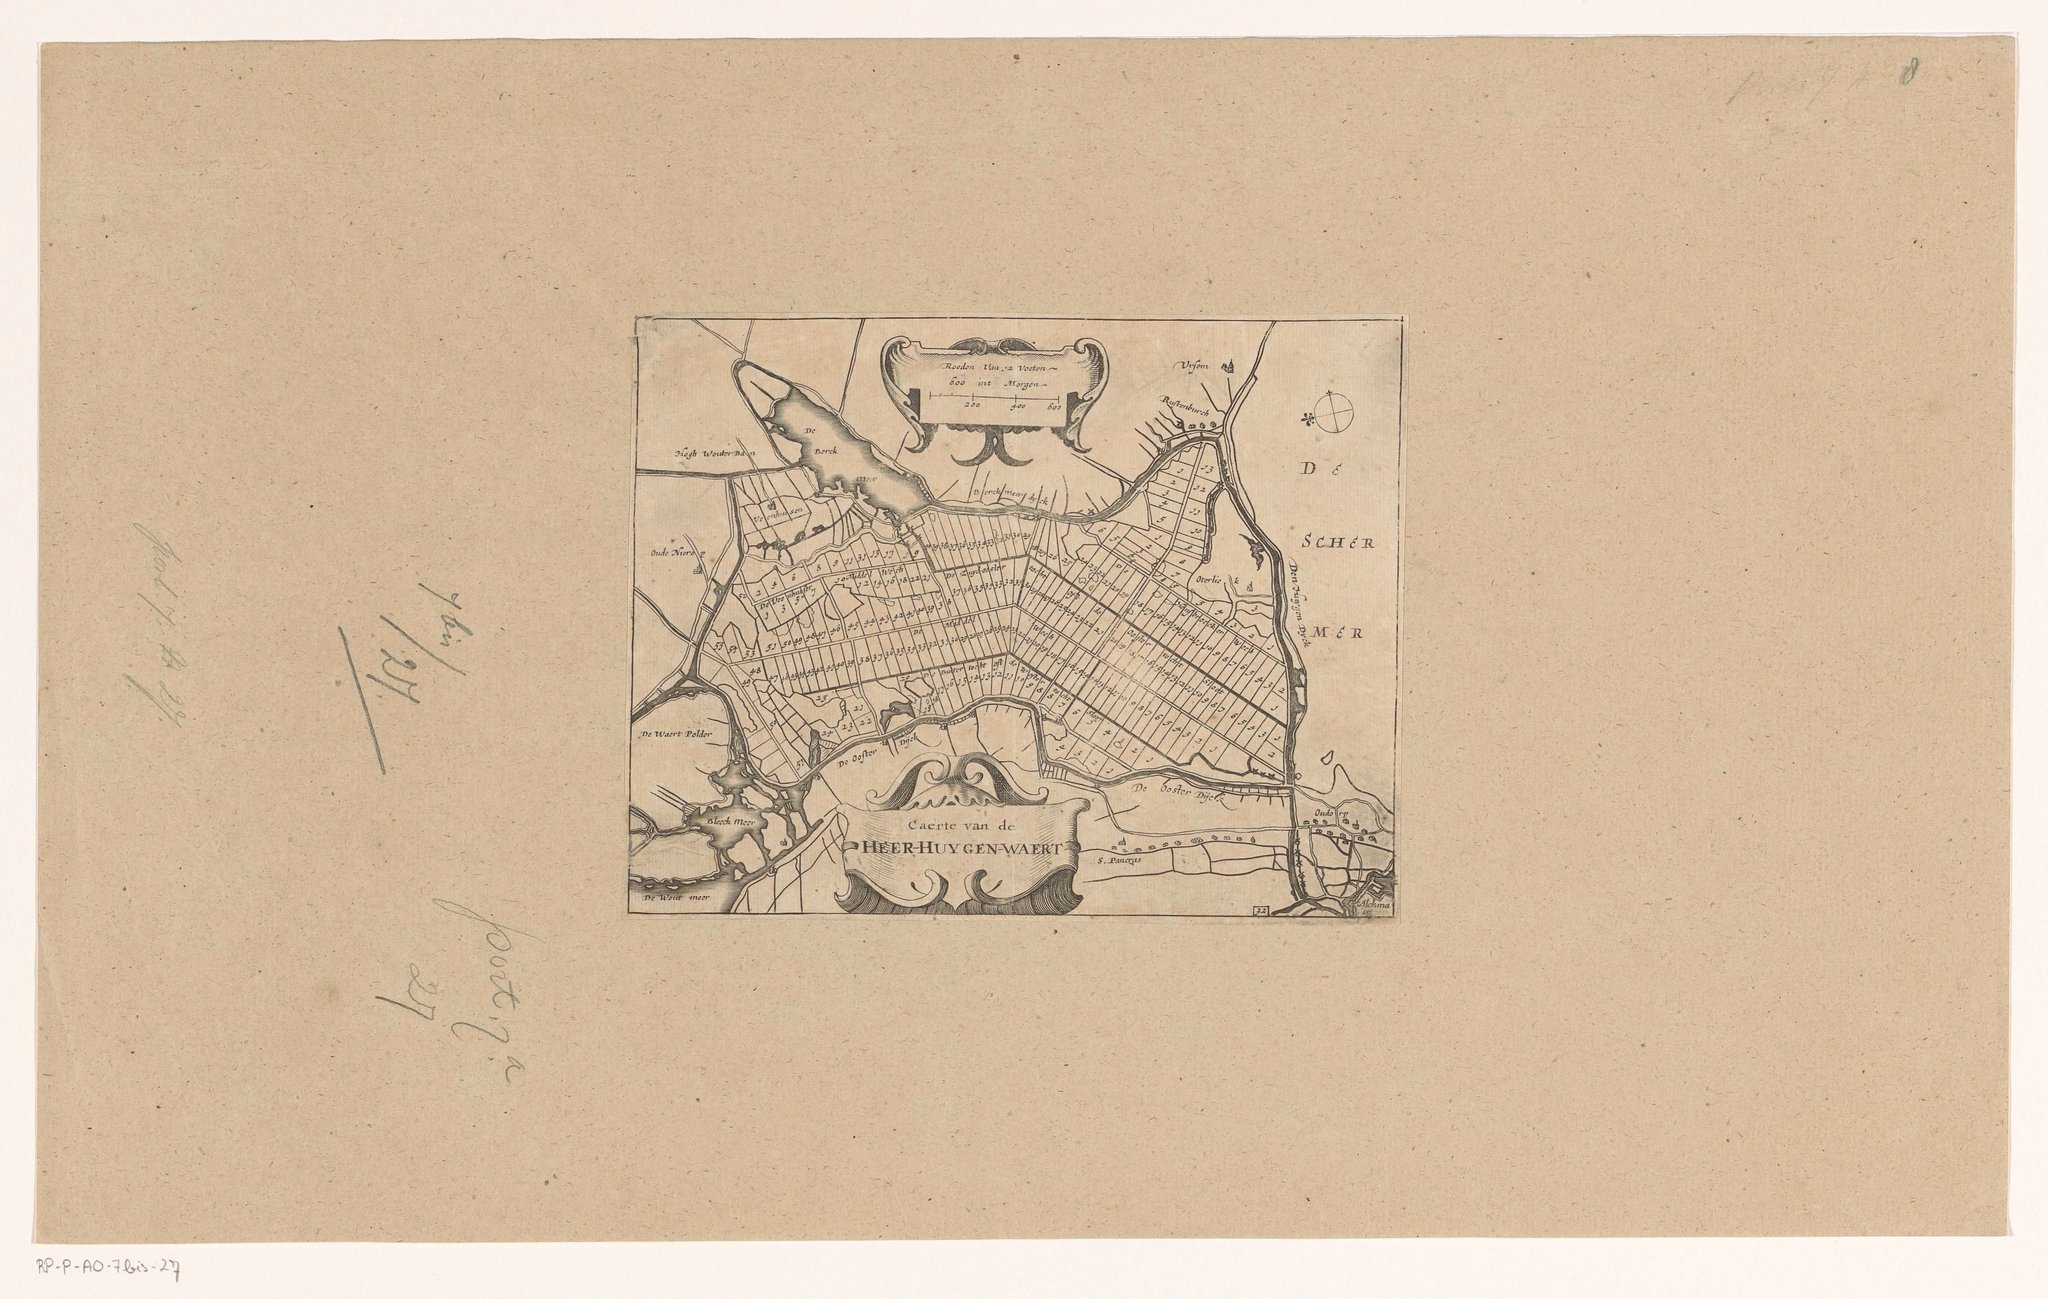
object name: print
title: Kaart van de polder de Heerhugowaard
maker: Anonymous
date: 1635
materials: paper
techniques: engraving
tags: maps of separate countries or regions, polder, reclaimed land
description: Deze staat van prent ook gebruikt in: De vyerighe colom klaer vertoonende in vyftich onderscheydene curieuse caarten de XVII. Nederlantsche Provincien (…). Amsterdam: Jacob Aertsz Colom (I), s.a. [ca. 1660], tussen p. 130 en p. 131. En in latere uitgaven met de platen van deze publicatie, uitgegeven door Pieter van Alphen (1691) en Pieter van der Slaart (1696). Zie documentatie voor meer informatie. Eerdere staat van prent (zonder ‘32’ rechtsonder) ook gebruikt in eerdere drukken van deze publicatie.